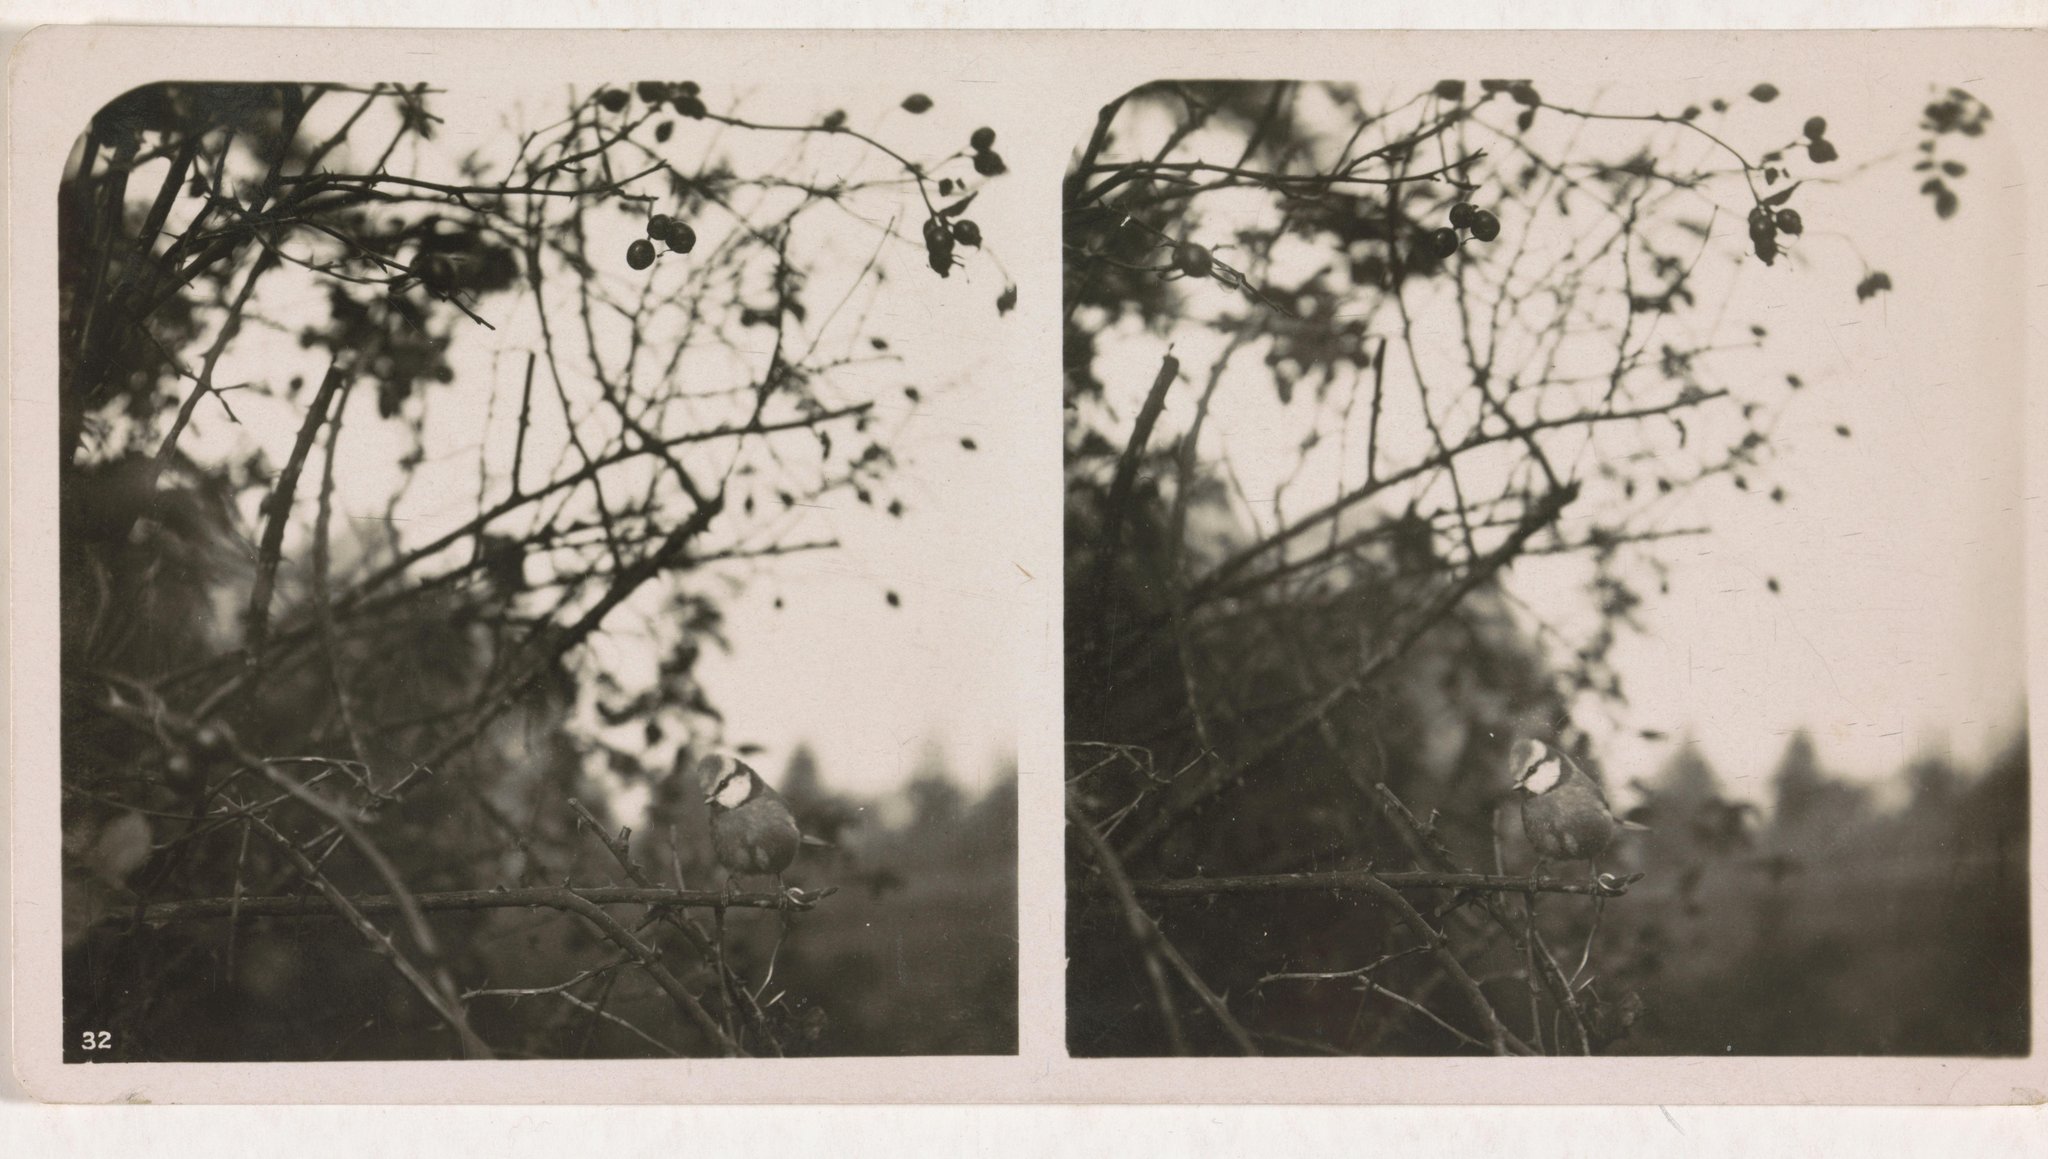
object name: stereograph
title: Les oiseaux et leurs nids / 2e Série Les oiseaux chanteurs (Suite).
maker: adolphe burdet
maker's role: fotograaf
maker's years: 1860-1940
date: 1870-1940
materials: photographic support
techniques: gelatin silver print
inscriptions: label: ‘32 / Parus caeruleus L. / Mésange bleue / Pimpelmees...’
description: Linksonder op de foto links staat het nummer 32. Uit serie van 25 stereofoto's.